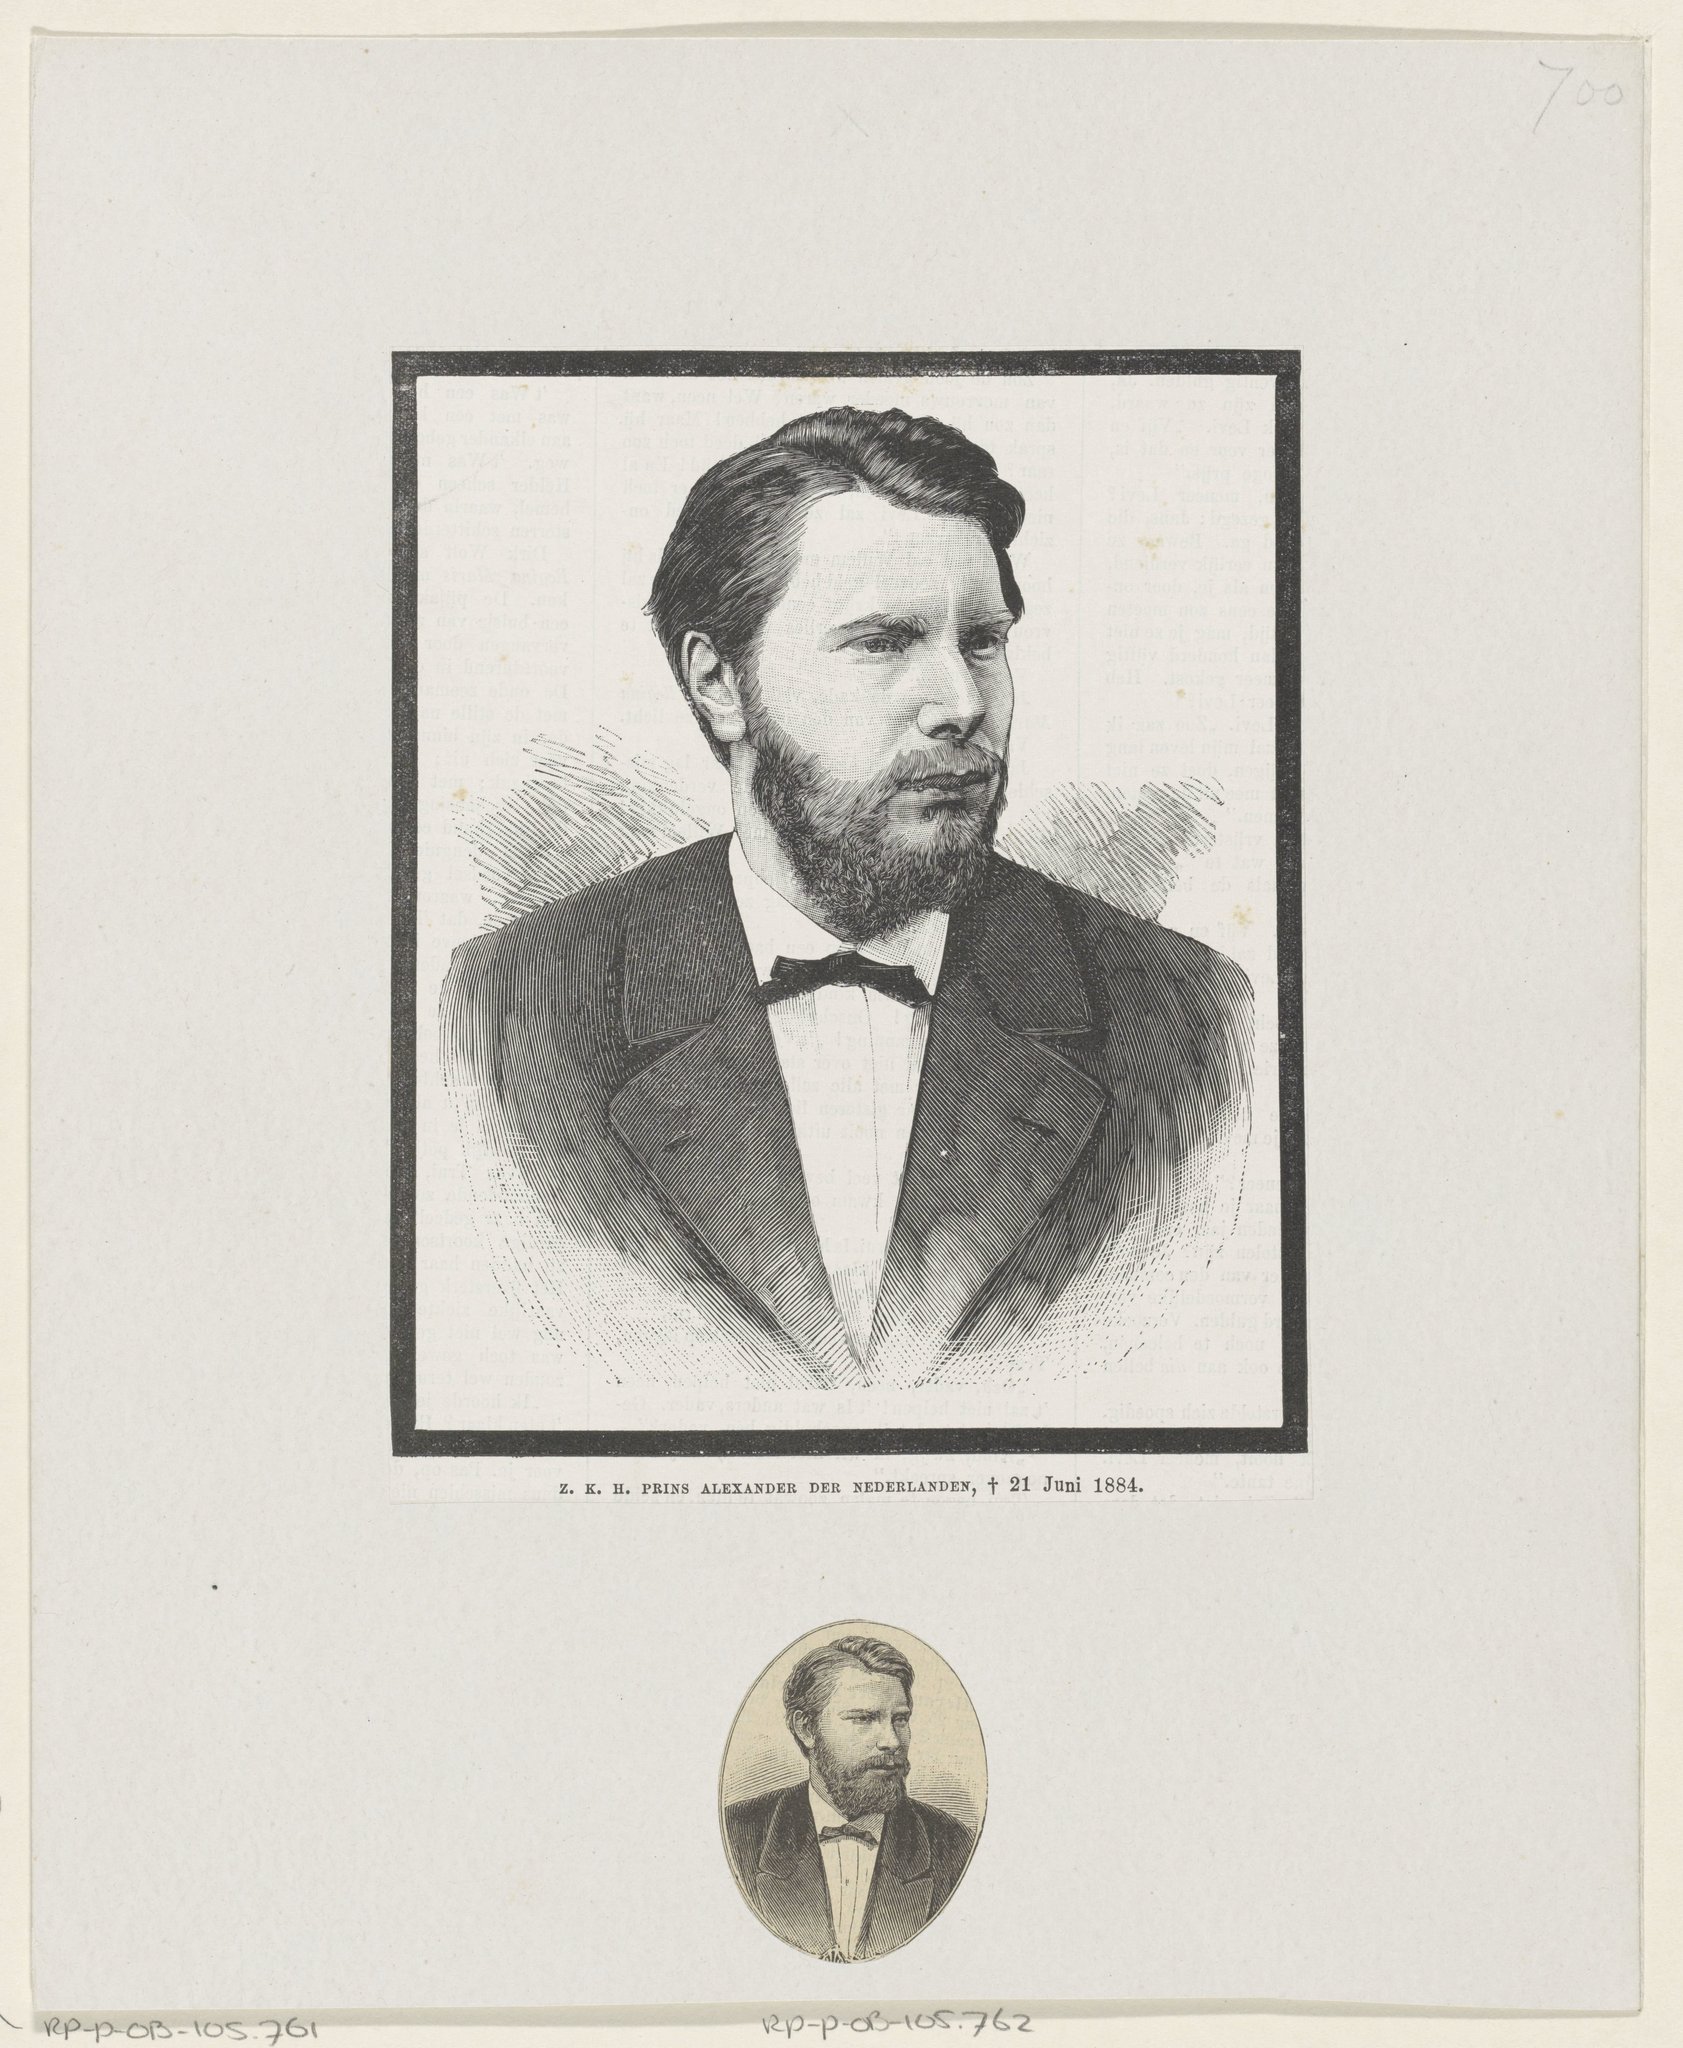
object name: book illustration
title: Portret van Alexander, prins der Nederlanden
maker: Anonymous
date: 1884-1949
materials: paper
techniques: letterpress printing, engraving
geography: netherlands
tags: the hague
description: De hier vermelde titel verwijst naar de hoogst verkregen titel van de geportretteerde, niet per se naar de titel die de geportretteerde op deze voorstelling draagt.